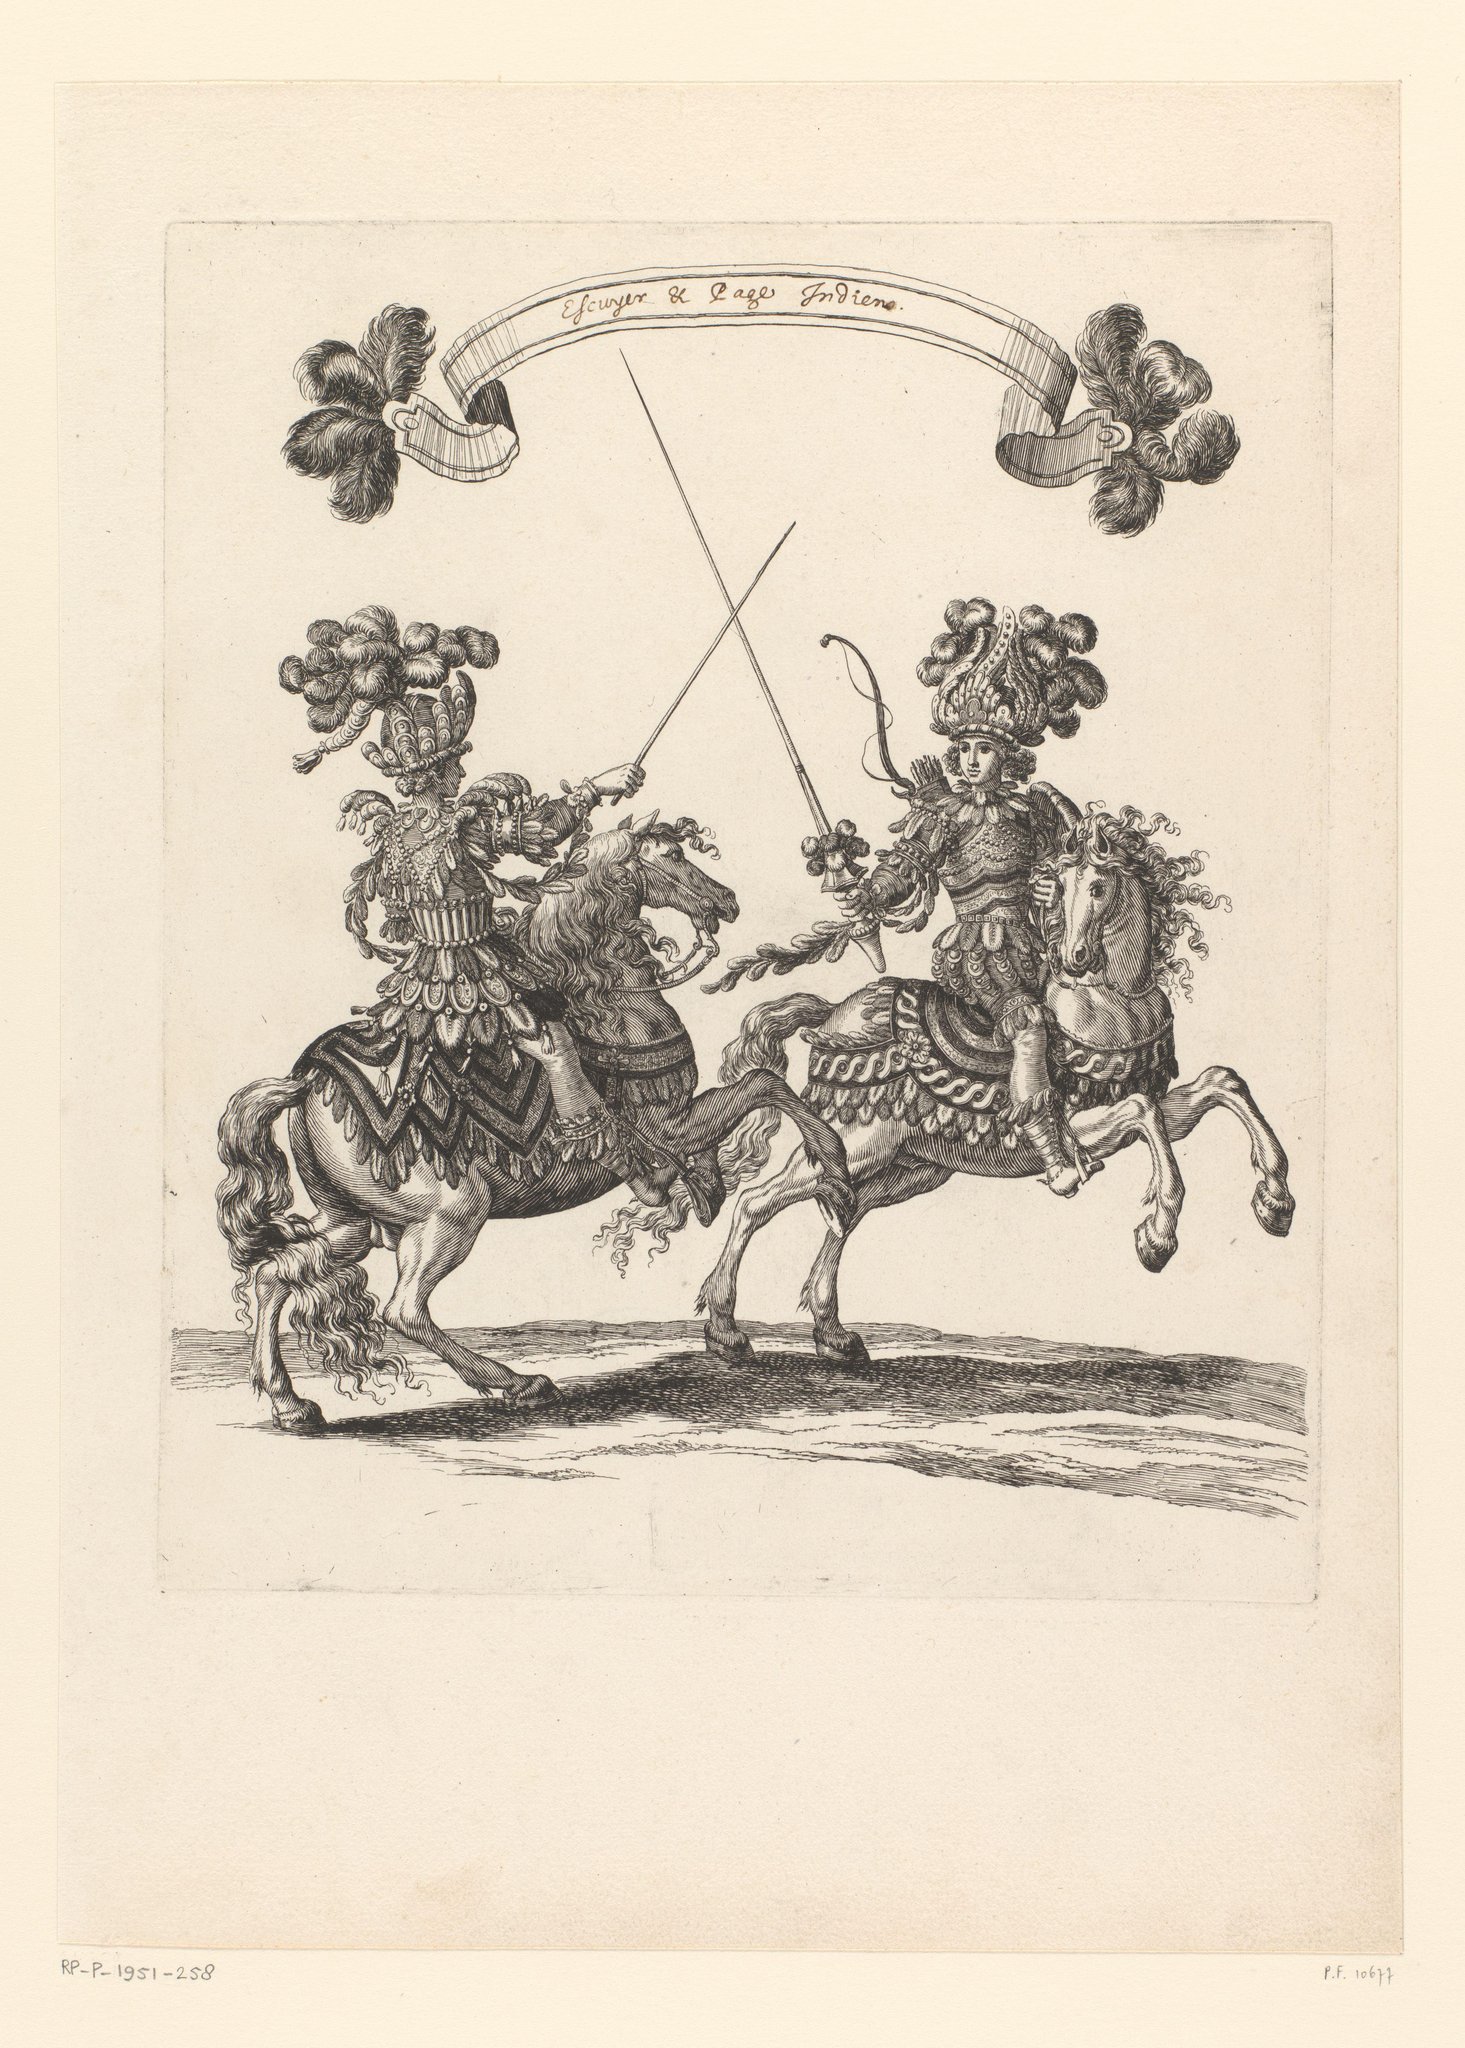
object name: book illustration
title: Steekspeler en page te paard in fantasiekostuum, aangeduid als 'Indiens'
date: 1670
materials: paper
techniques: etching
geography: france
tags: dress-up party, indigenous peoples of north america (+ costume), tournament, joust, tilt, horse, festivities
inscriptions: inscription, collector's mark: Lugt 2228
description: Prent uit: Perrault, Charles. Courses de testes et de bague faites par le Roy et par les princes et seigneurs de sa cour en l'année M.DC.LXII. Parijs: Imprimerie Royale, 1670. De prenten illustreren de door Lodewijk XIV georganiseerde festiviteiten in juni 1662 te Tuileries, zoals steekspelen met figuren in verschillende kostuums.